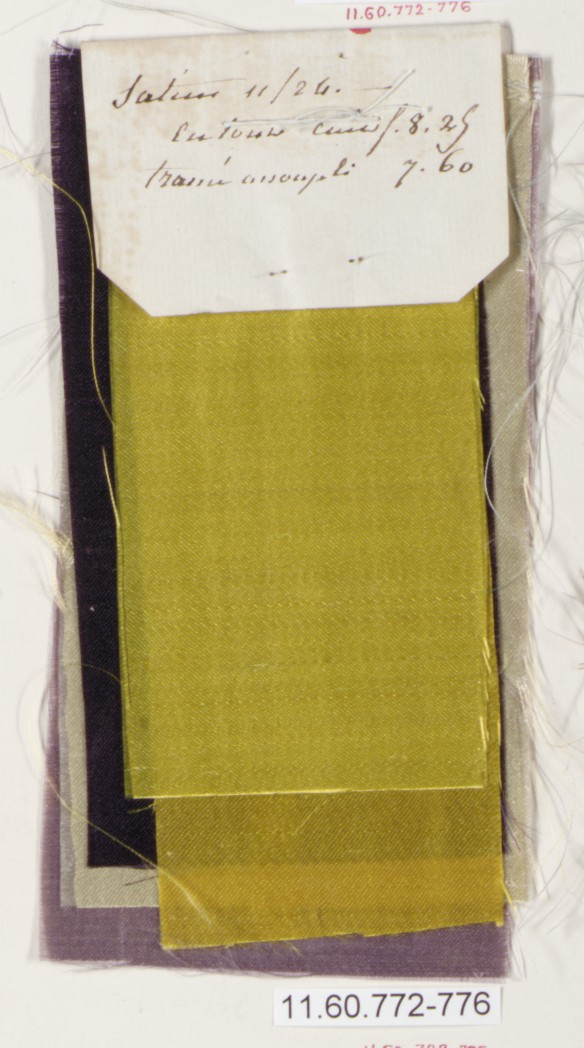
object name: sample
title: Samples (5)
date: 1801-1833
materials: silk